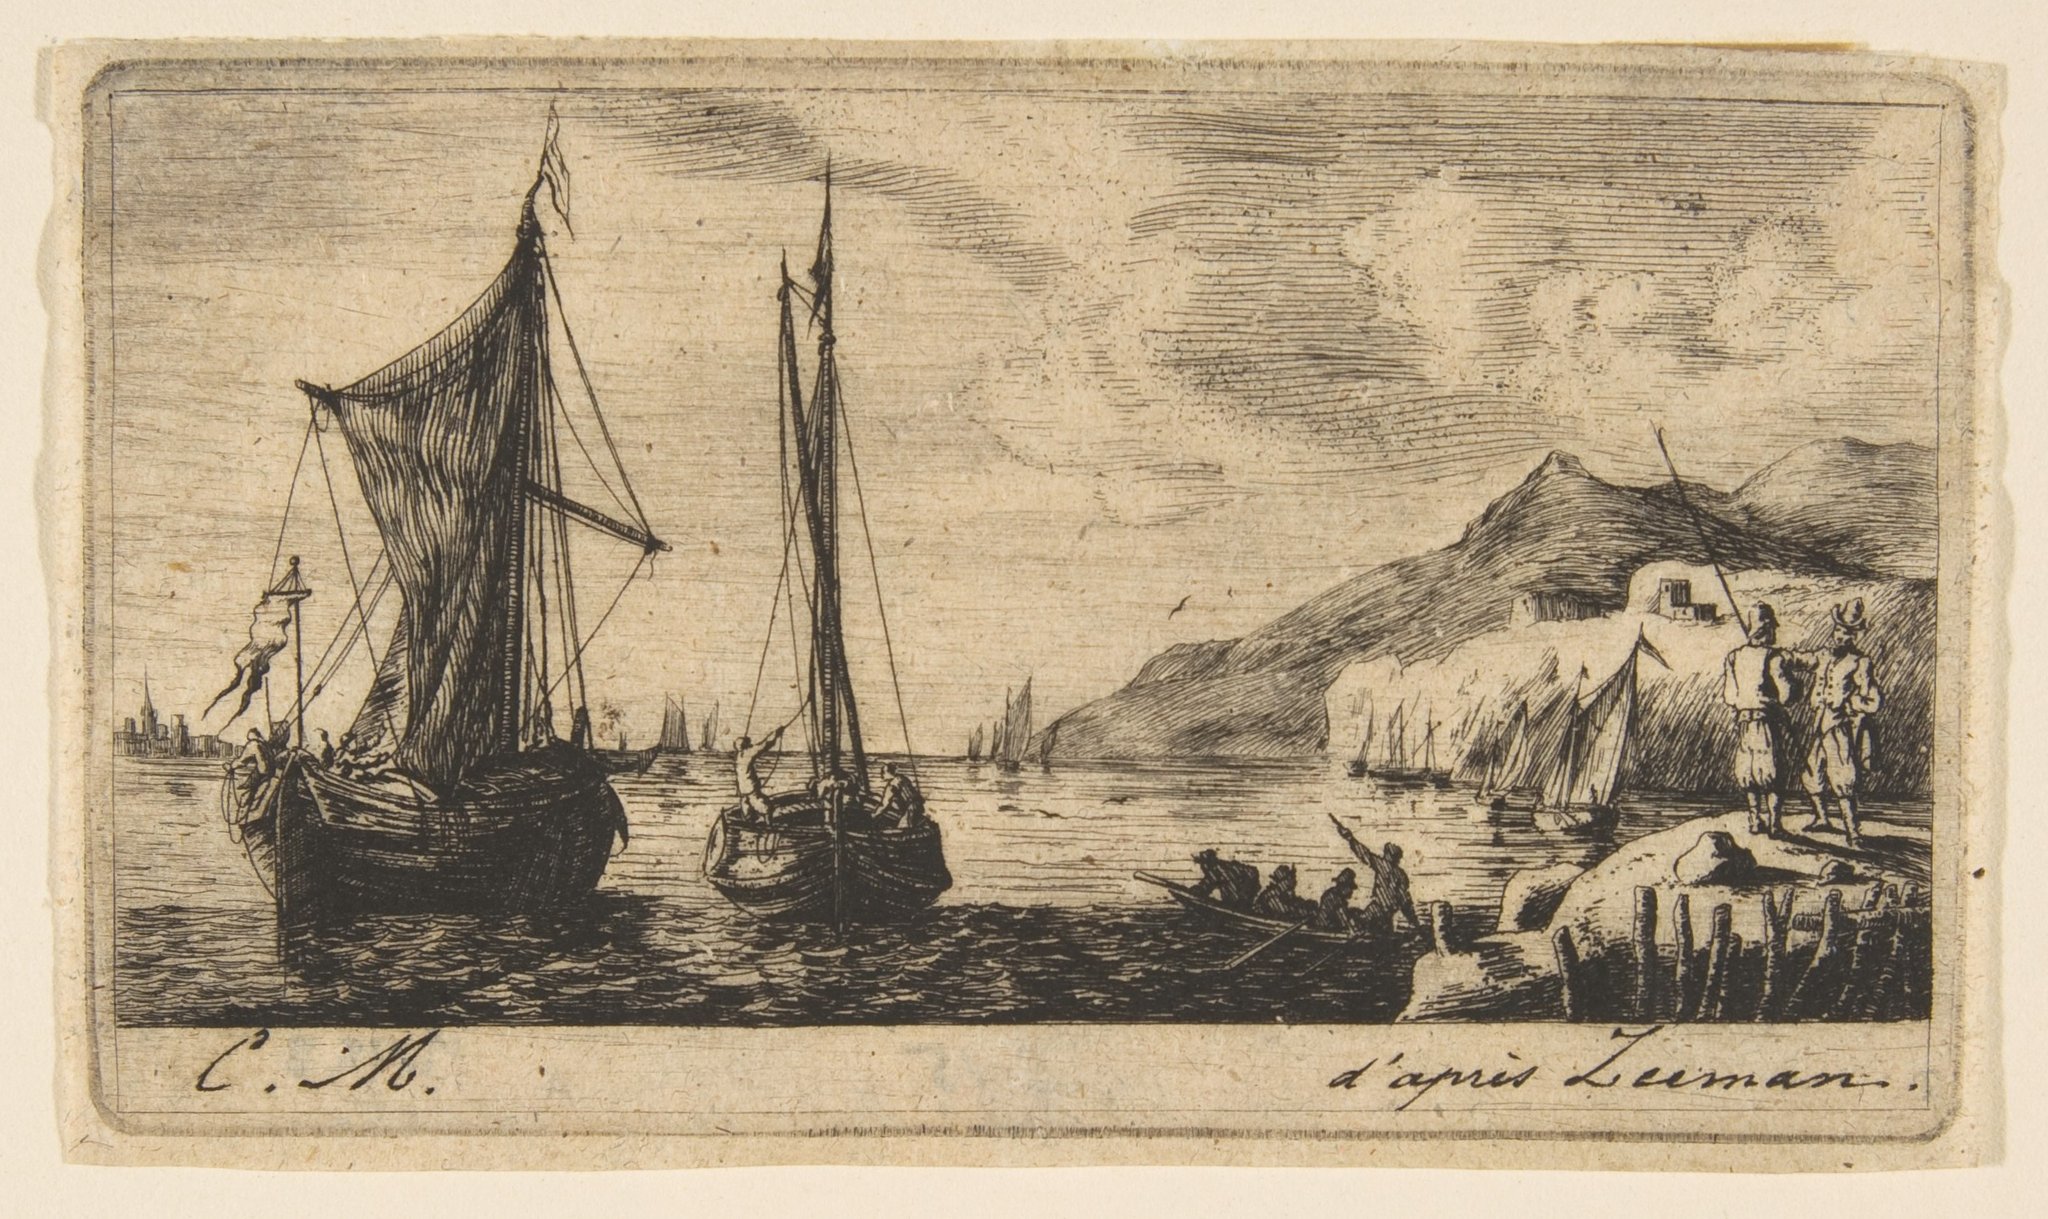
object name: print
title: Calais Boats in Vlissingen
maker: charles meryon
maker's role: artist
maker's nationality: french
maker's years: 1821-1868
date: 1850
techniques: etching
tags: ships